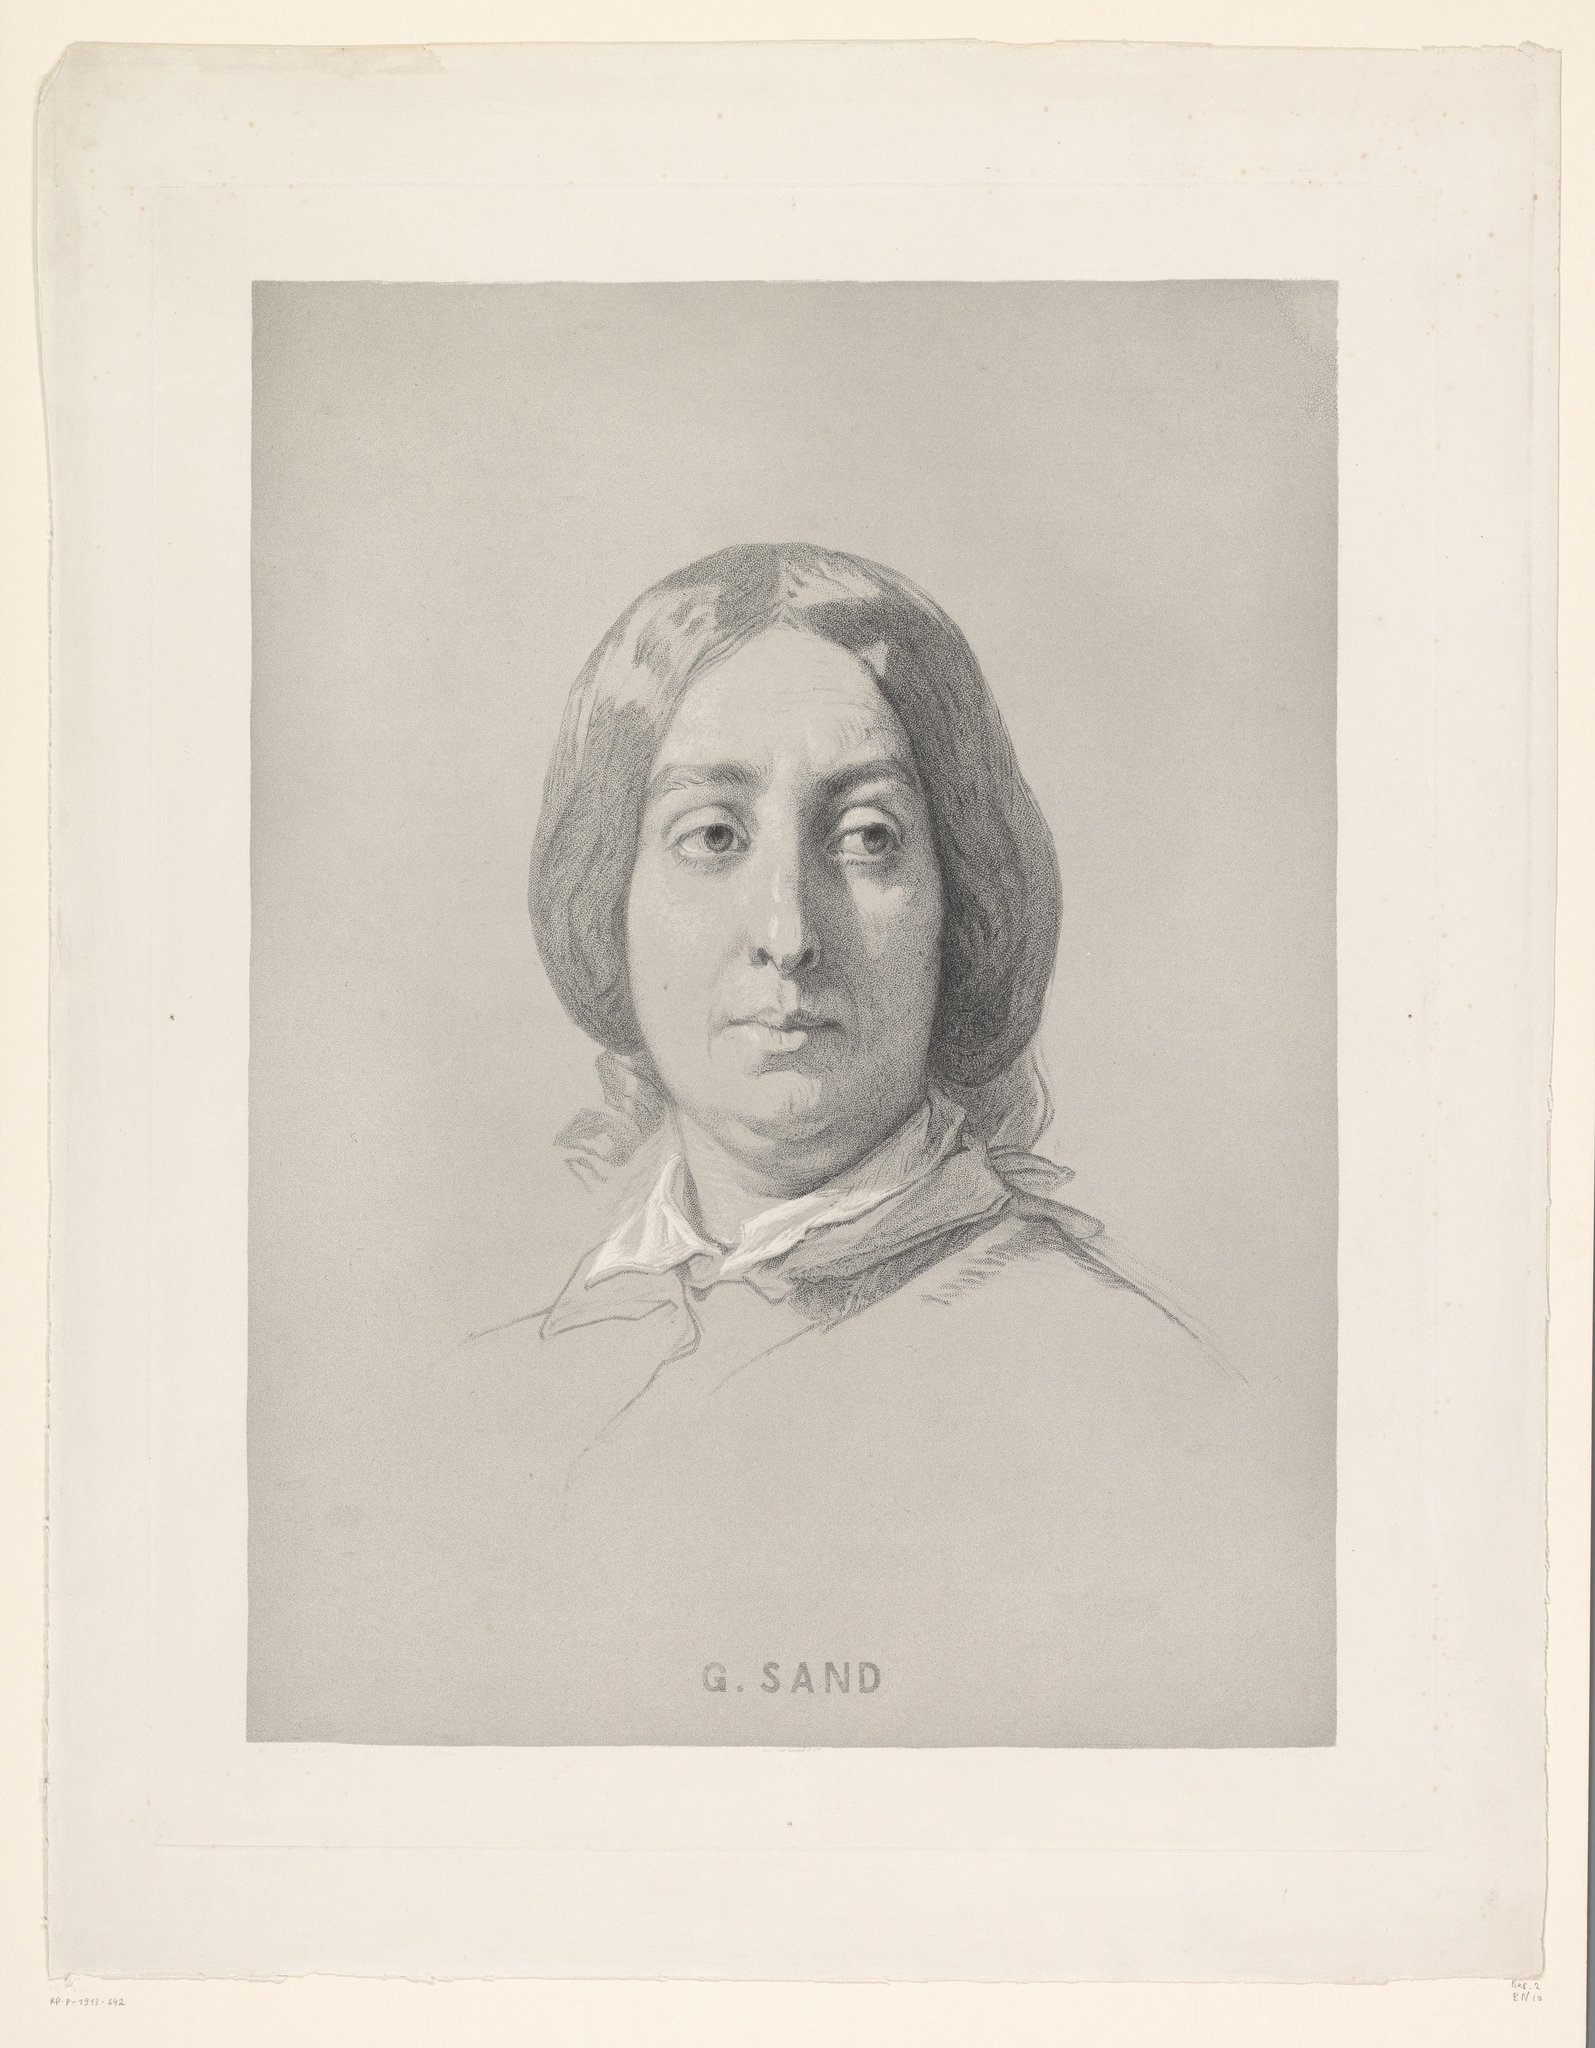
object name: print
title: G. Sand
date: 1827-1865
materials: paper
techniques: printmaking, engraving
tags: paris, george sand, historical persons - bb - woman, portrait of a writer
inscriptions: collector's mark: Lugt 2233